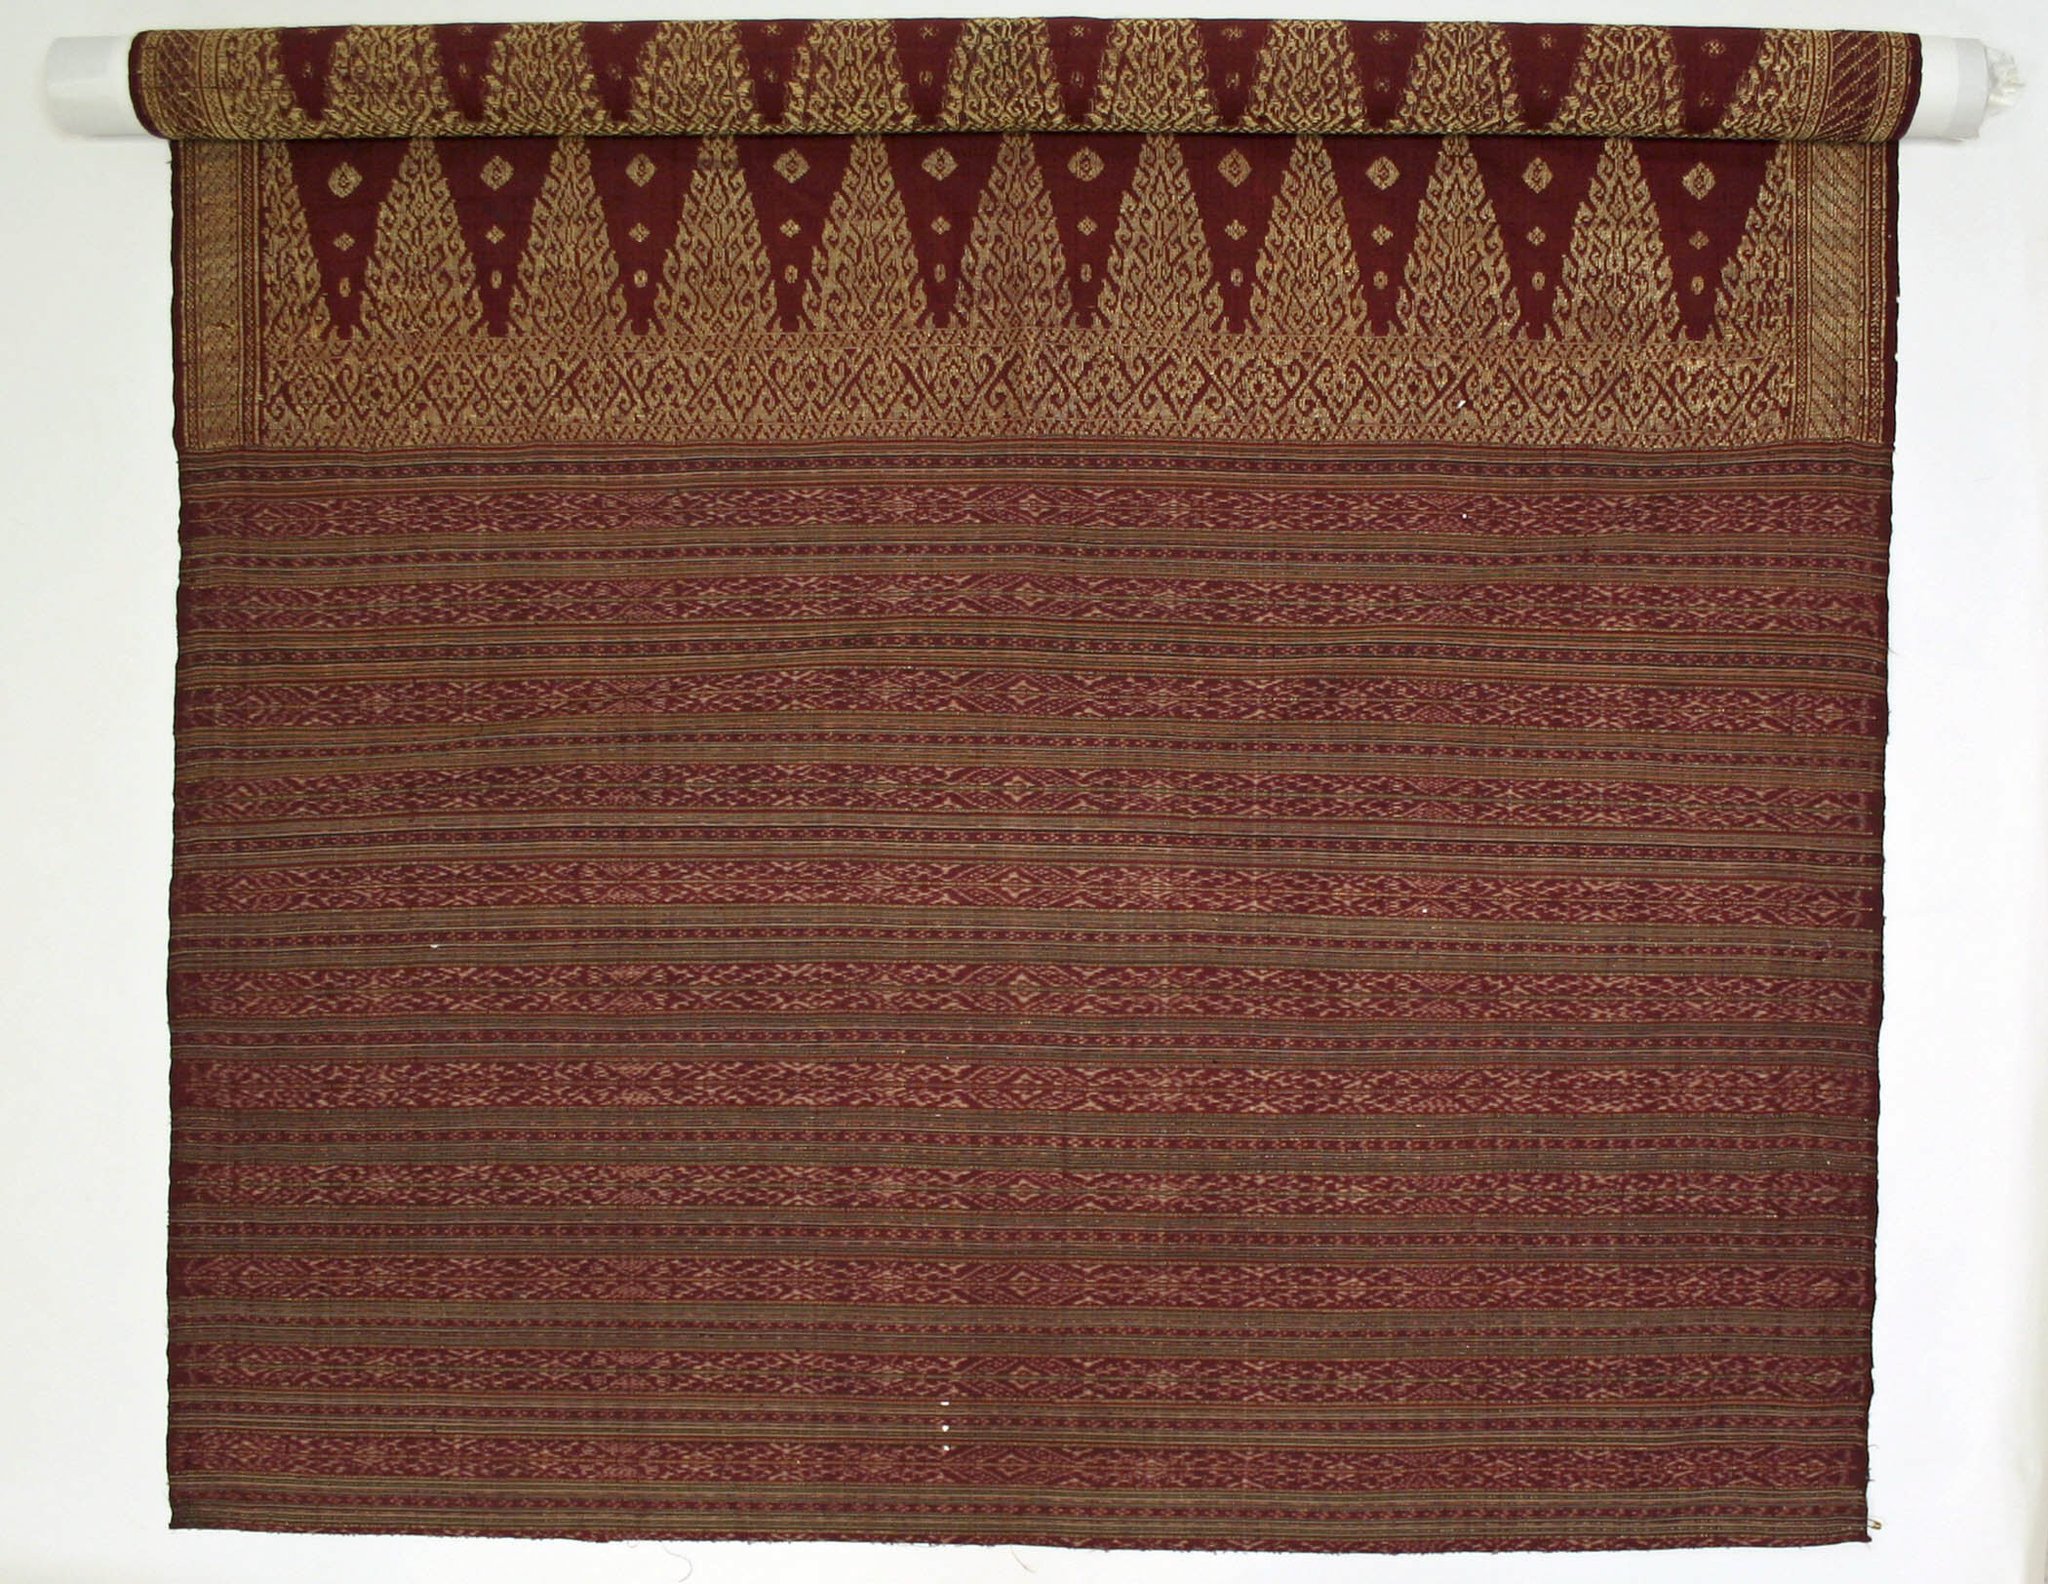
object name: sarong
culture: malaysian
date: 1801-1900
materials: metal thread, silk